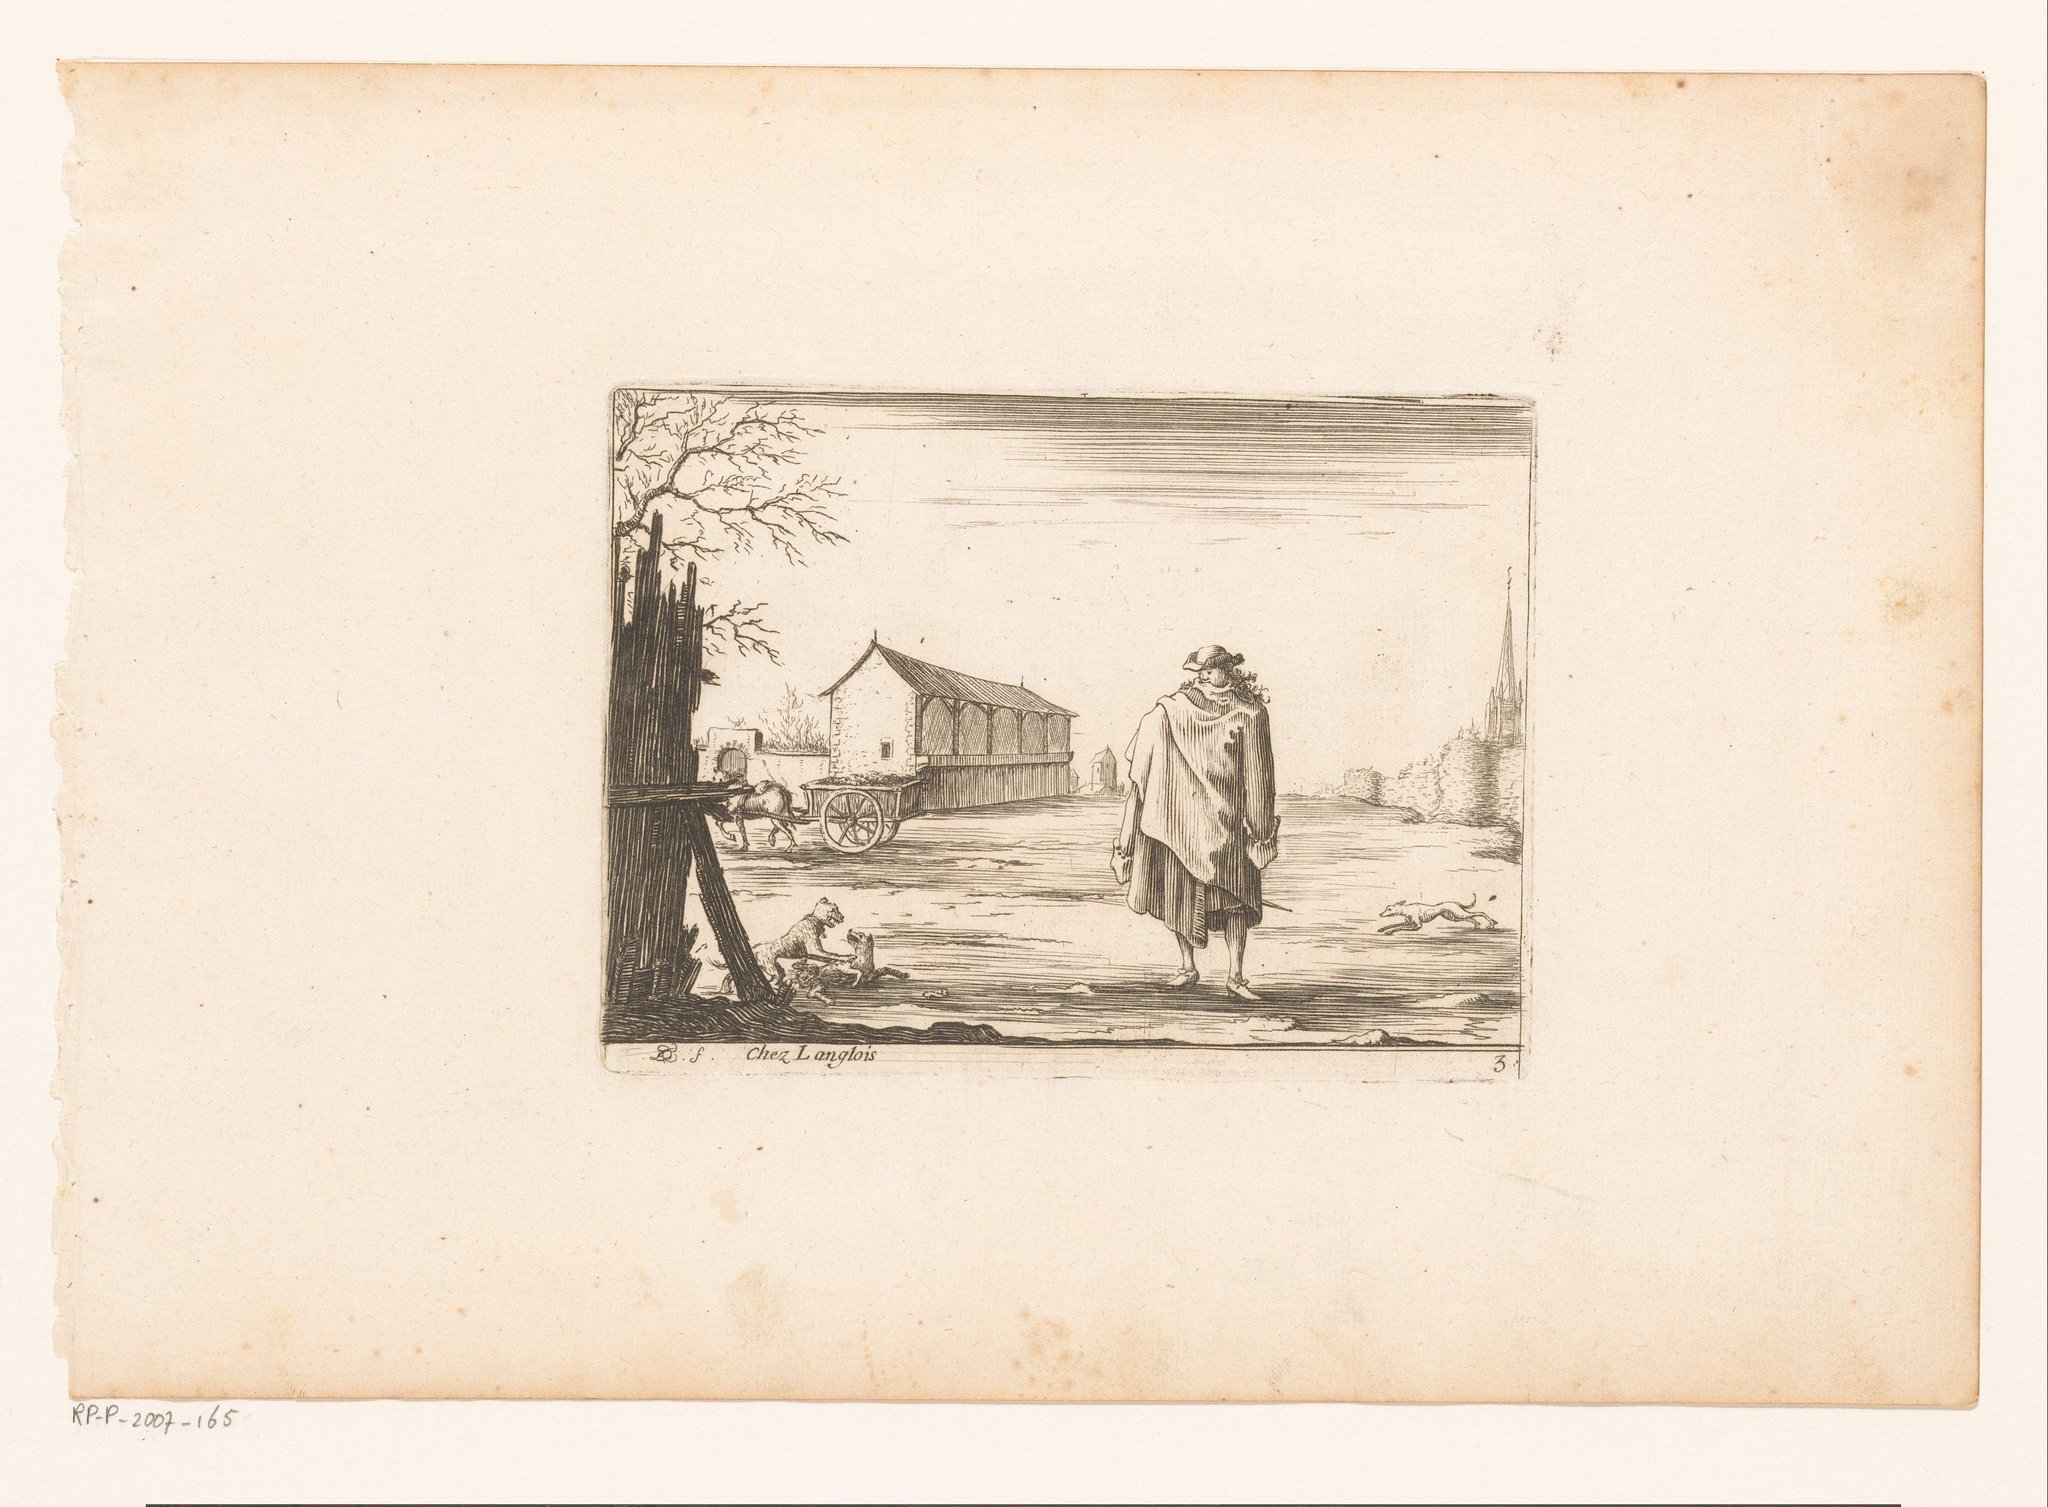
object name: print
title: Diverses figures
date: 1670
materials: paper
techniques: etching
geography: paris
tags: adult man, clothes, costume (+ men's clothes), dog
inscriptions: collector's mark: Lugt 2760, collector's mark: Lugt 2228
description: Maakt deel uit van een serie van twaalf prenten met verschillende figuren, uitgegeven door Langlois in Parijs.